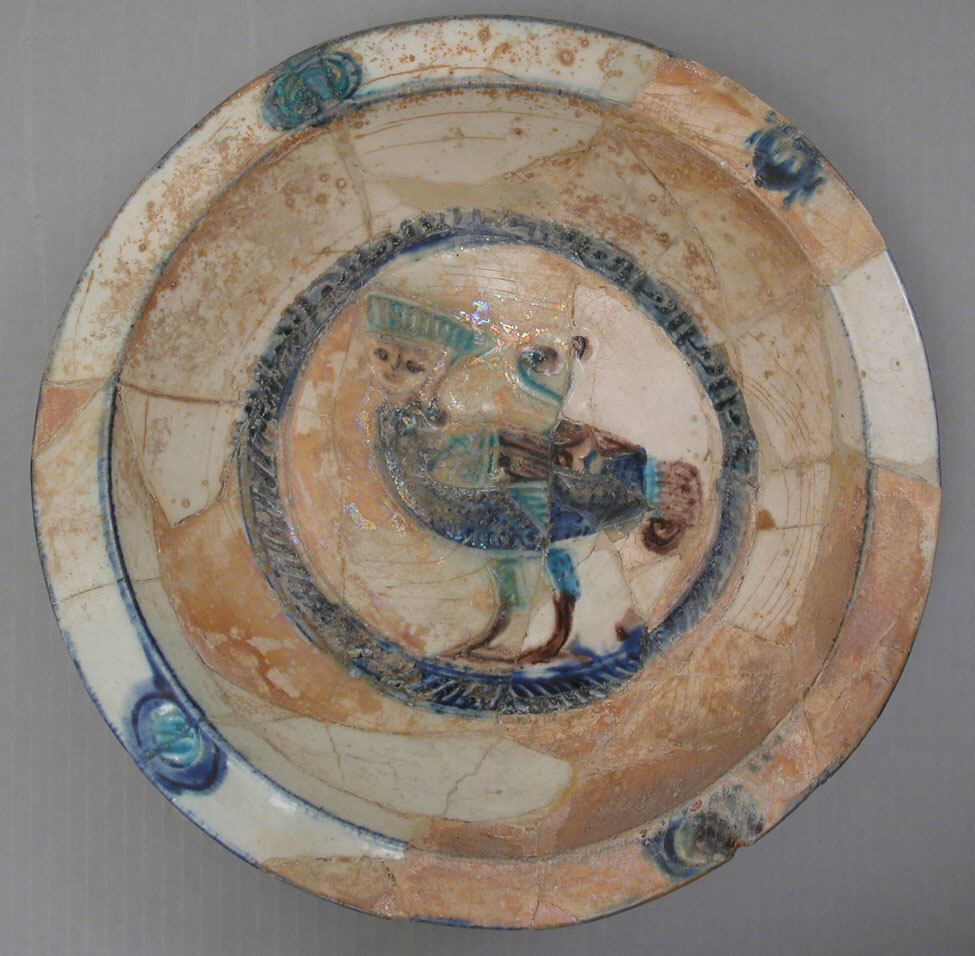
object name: bowl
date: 1101-1200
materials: earthenware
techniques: glazing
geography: iran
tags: mythical creatures